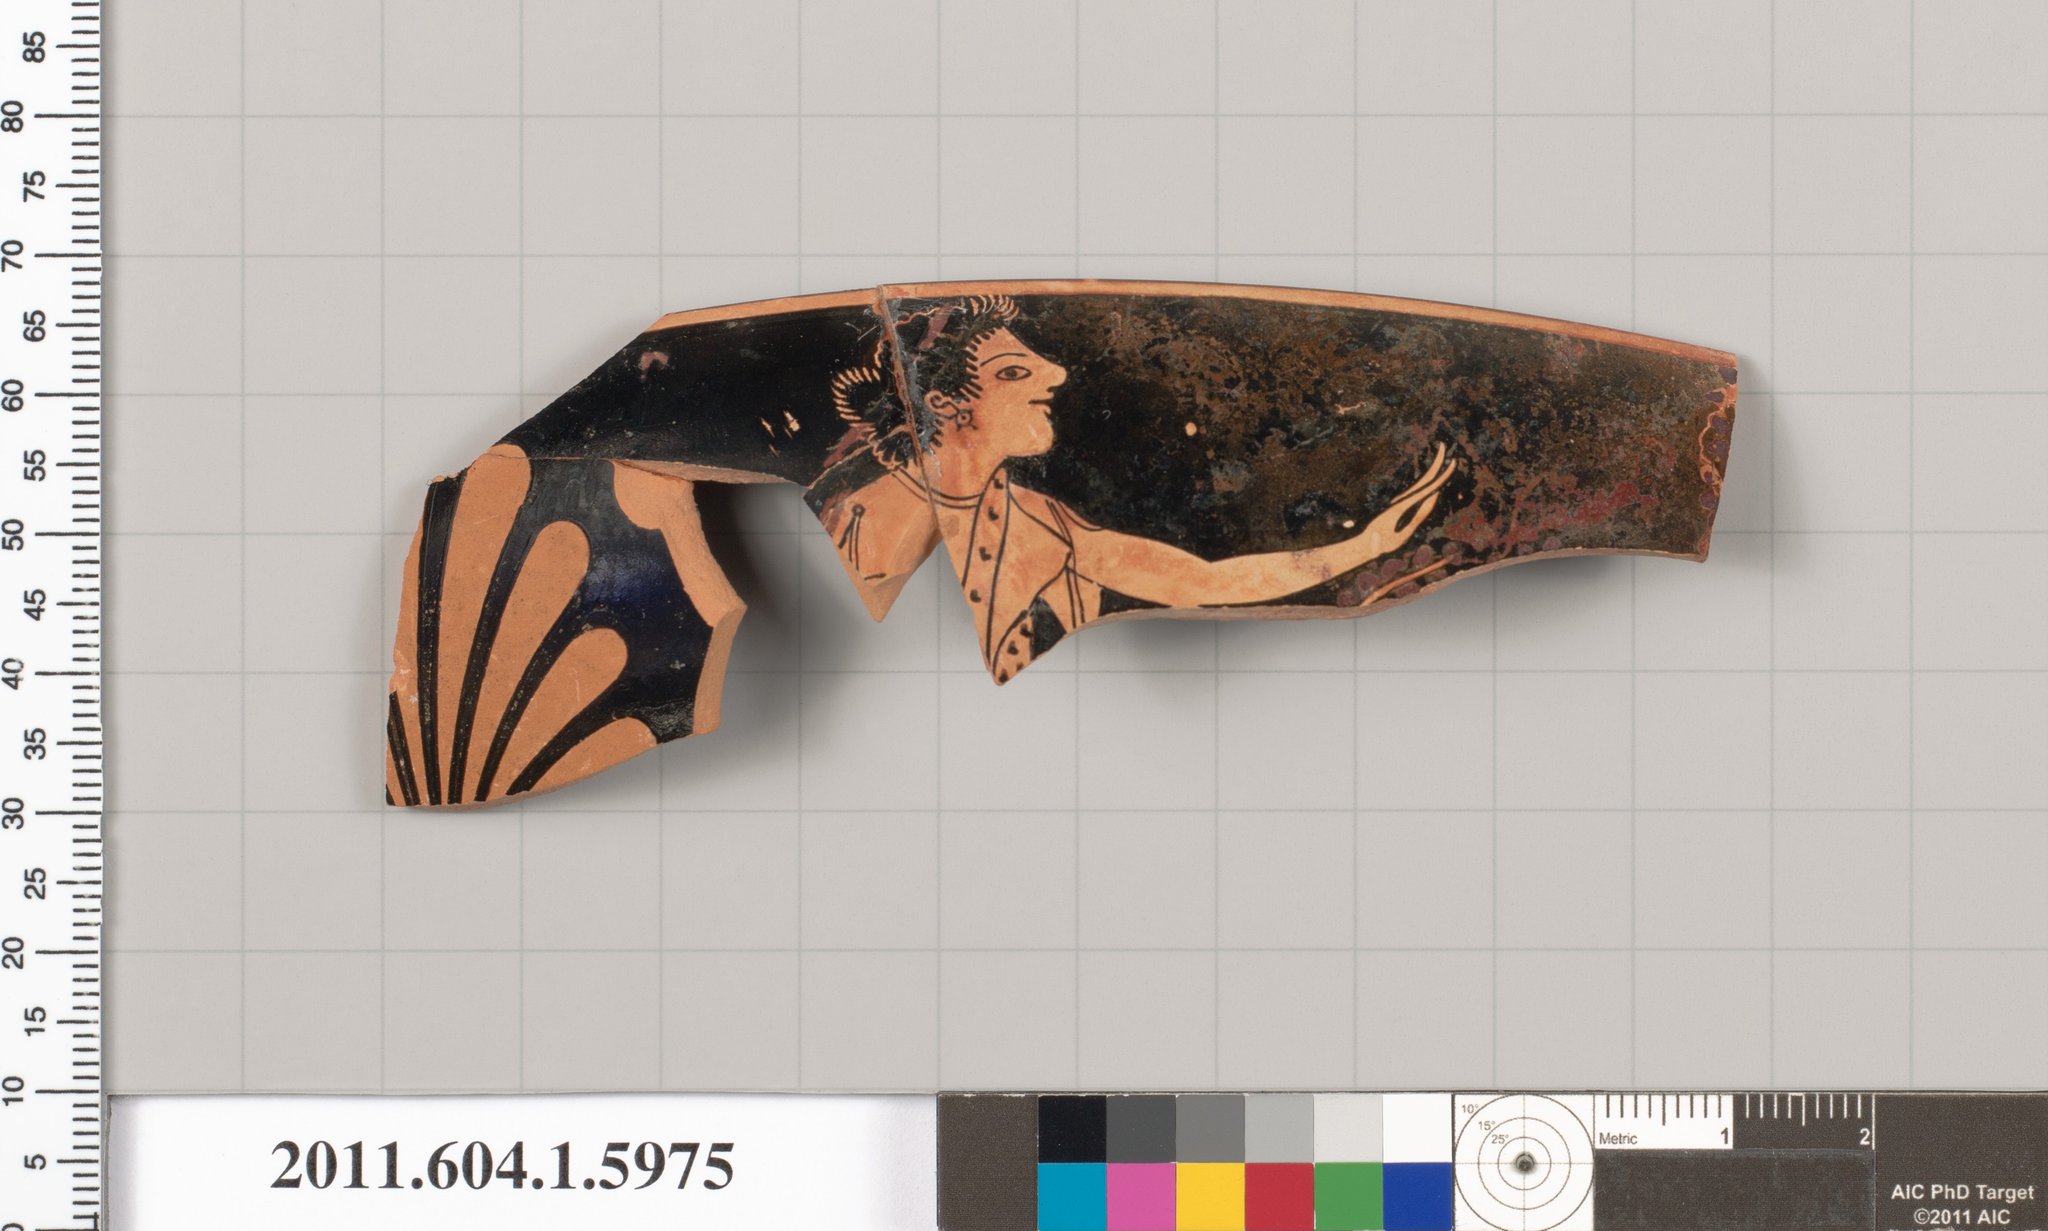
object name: kylix fragment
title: Terracotta rim fragment of a kylix (drinking cup)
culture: greek, attic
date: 433-567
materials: terracotta